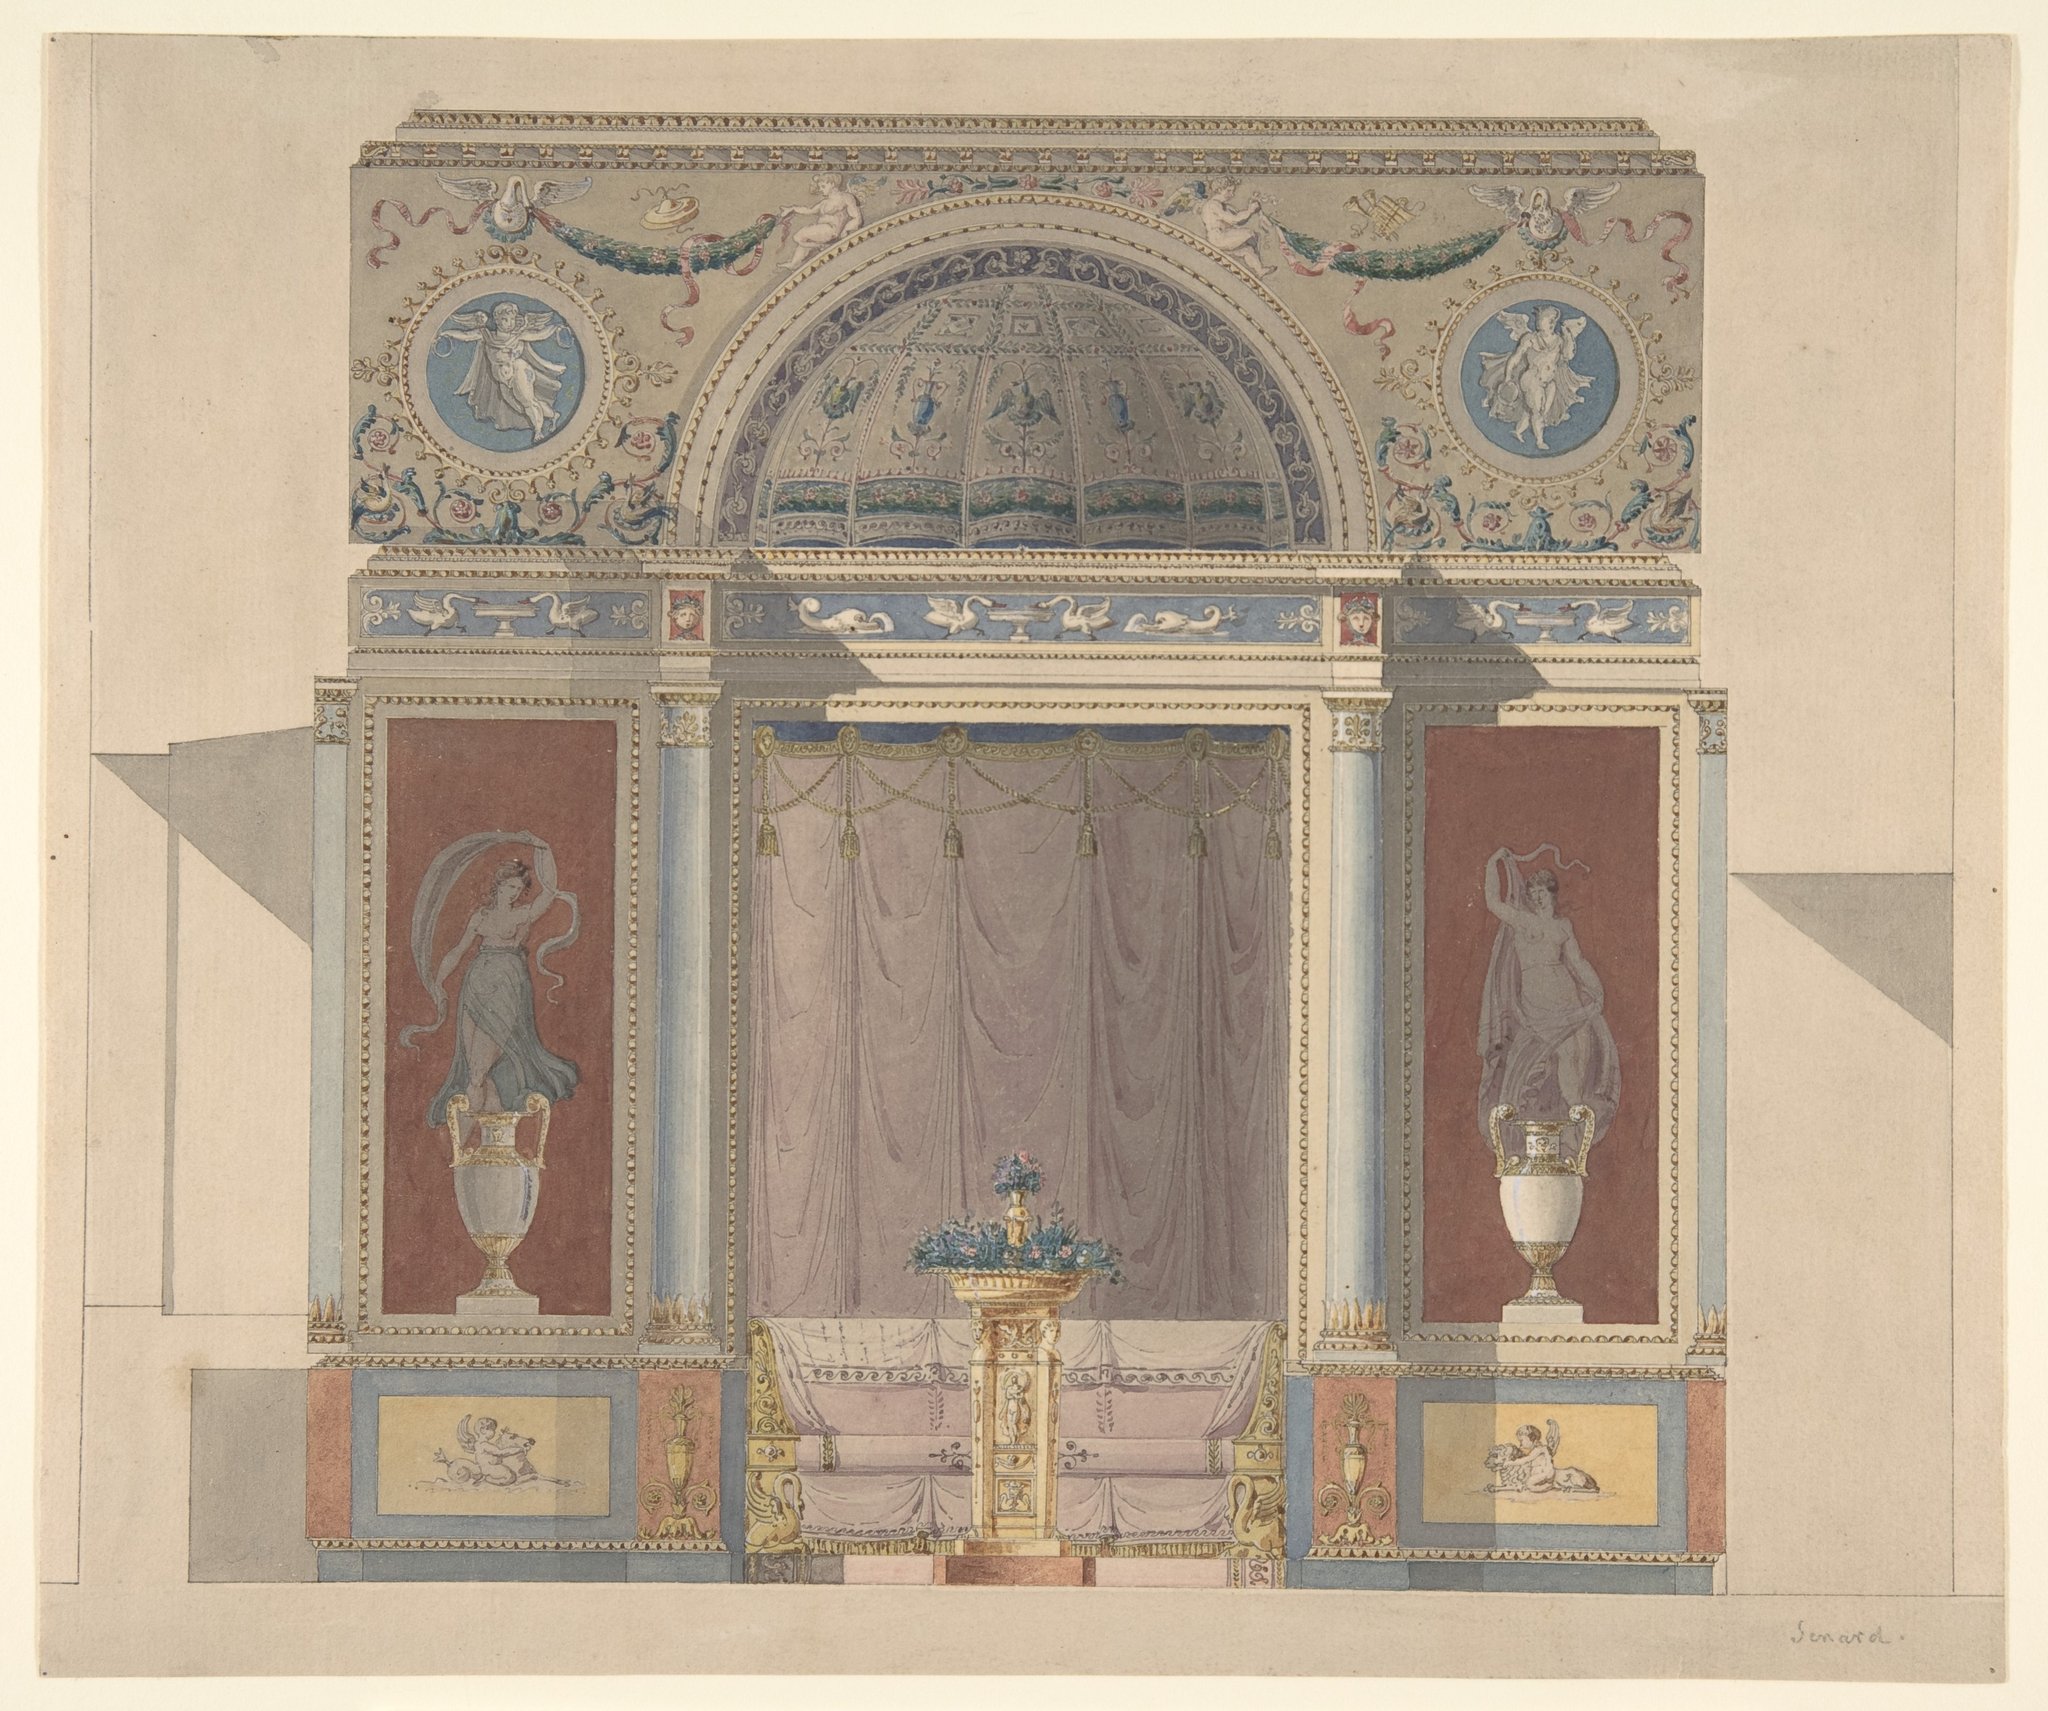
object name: drawing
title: Study for an Arched Alcove with a Canapé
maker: anonymous, french, 19th century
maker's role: artist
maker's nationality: french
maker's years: 1800-1900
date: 1804-1810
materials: ink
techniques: brush, pen, wash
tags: architecture